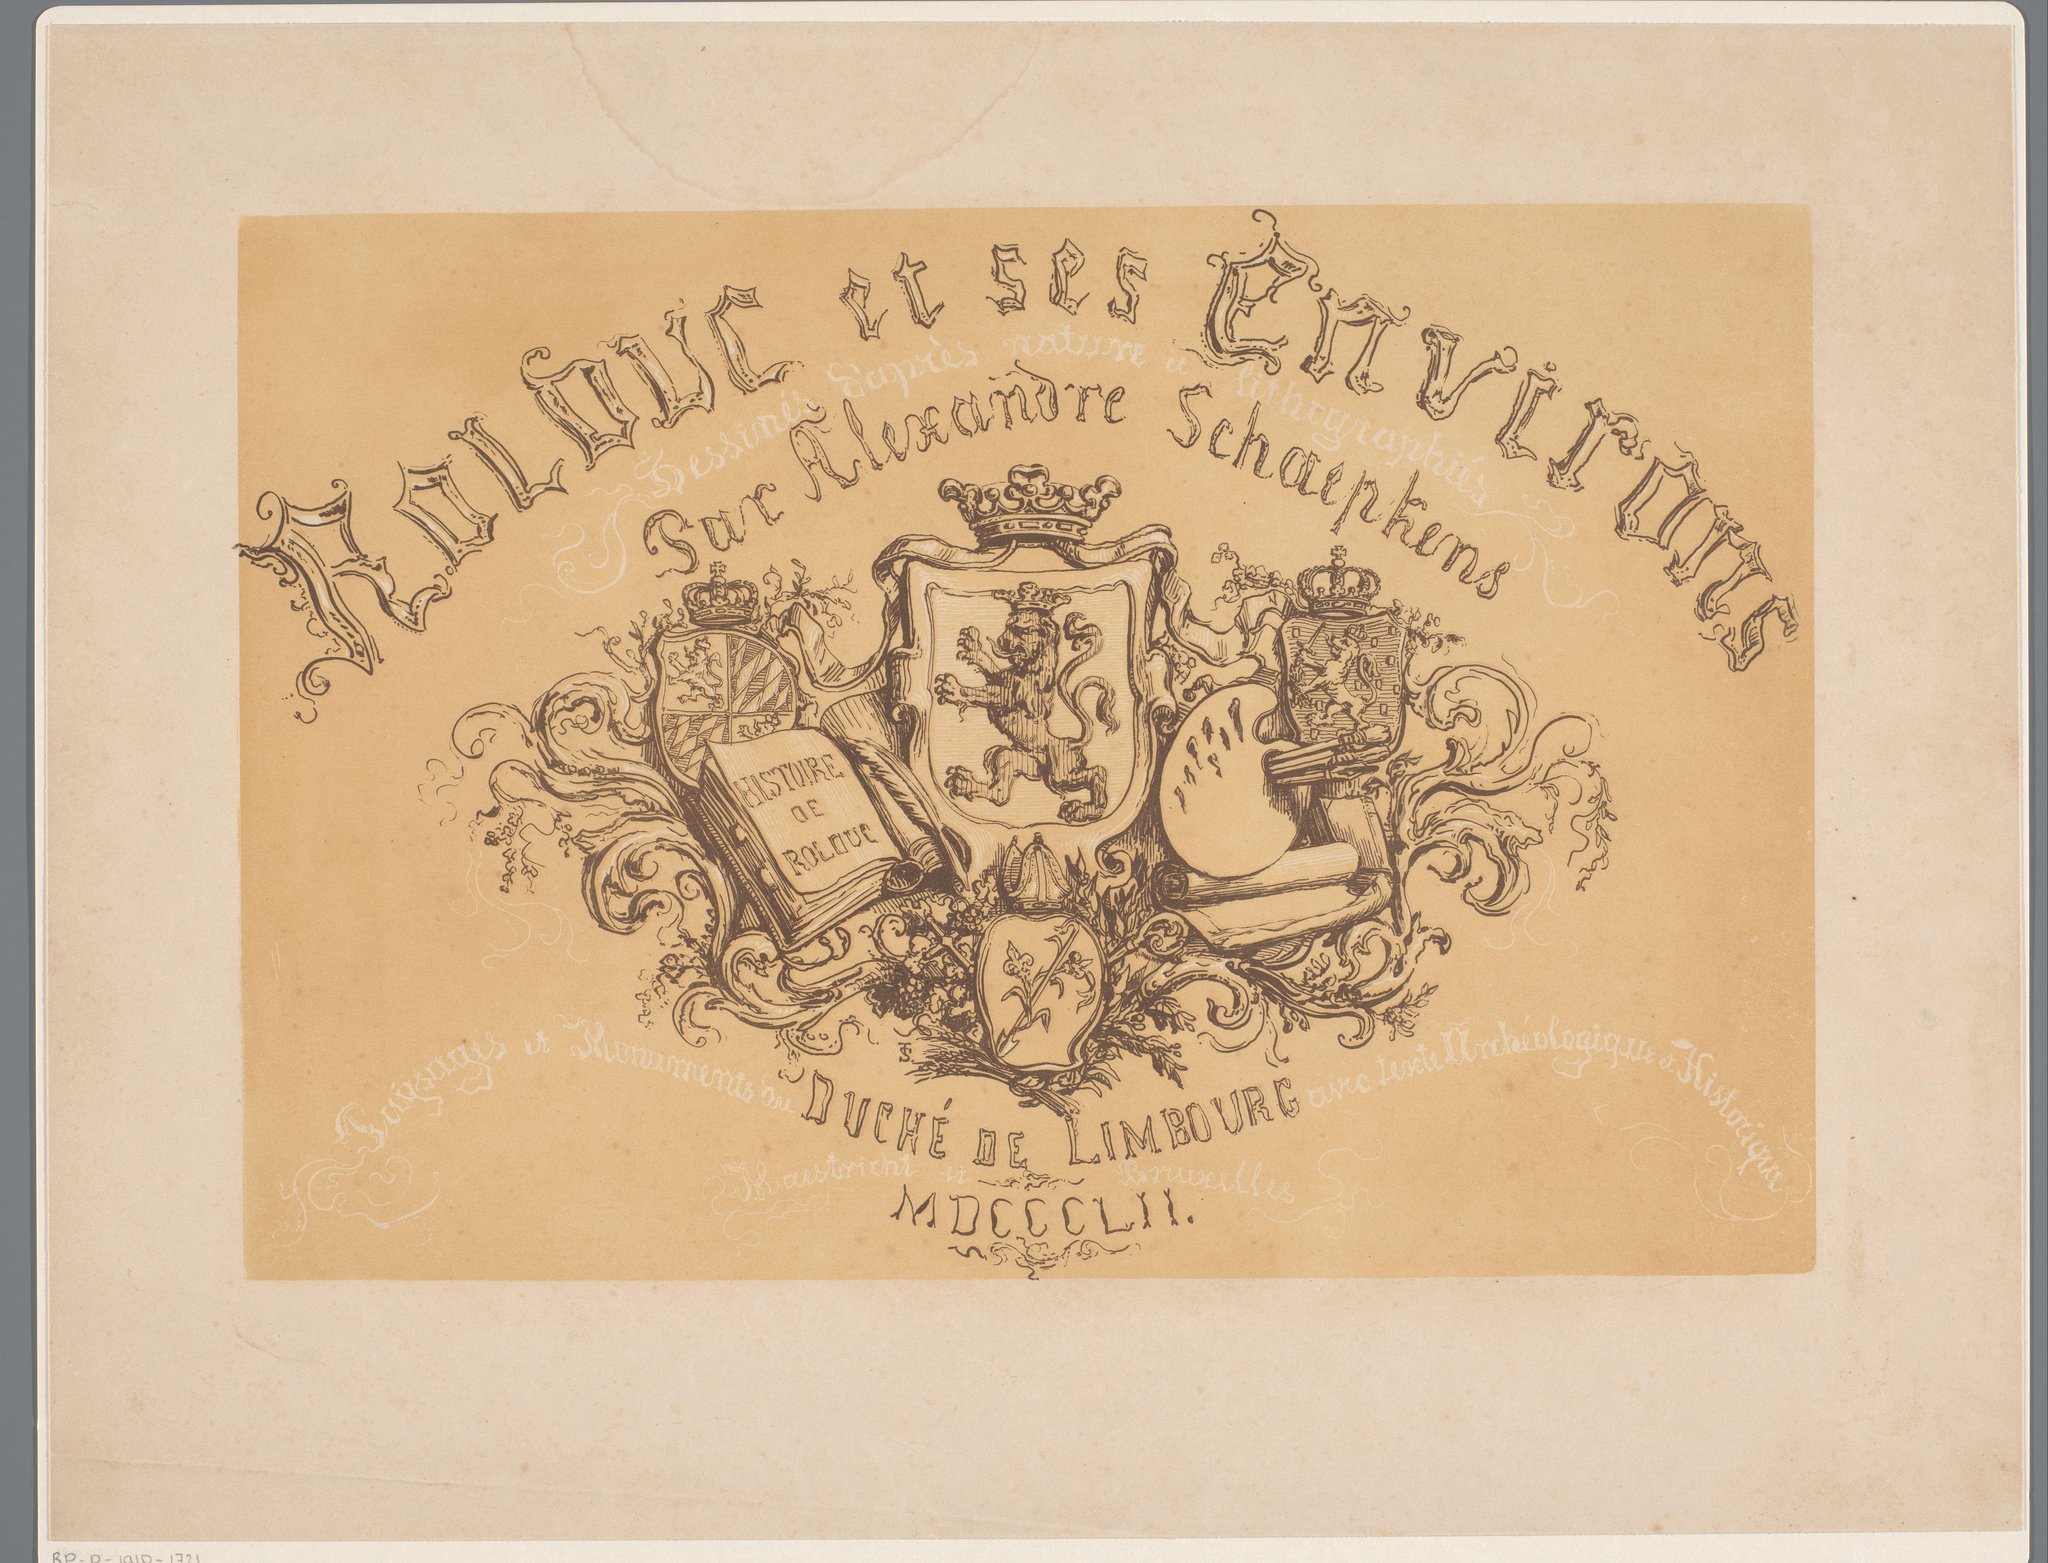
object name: titelprent, frontispice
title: Wapenschilden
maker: alexander schaepkens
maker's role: draughtsman, print maker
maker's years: 1815-1899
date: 1852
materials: paper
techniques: tone lithography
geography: brussels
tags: coat of arms (as symbol of the state, etc.)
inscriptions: collector's mark: Lugt 2228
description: Het gekroonde wapen van Limburg omringd door drie wapenschilden, een open boek, een schilderspalet en een boekrol.